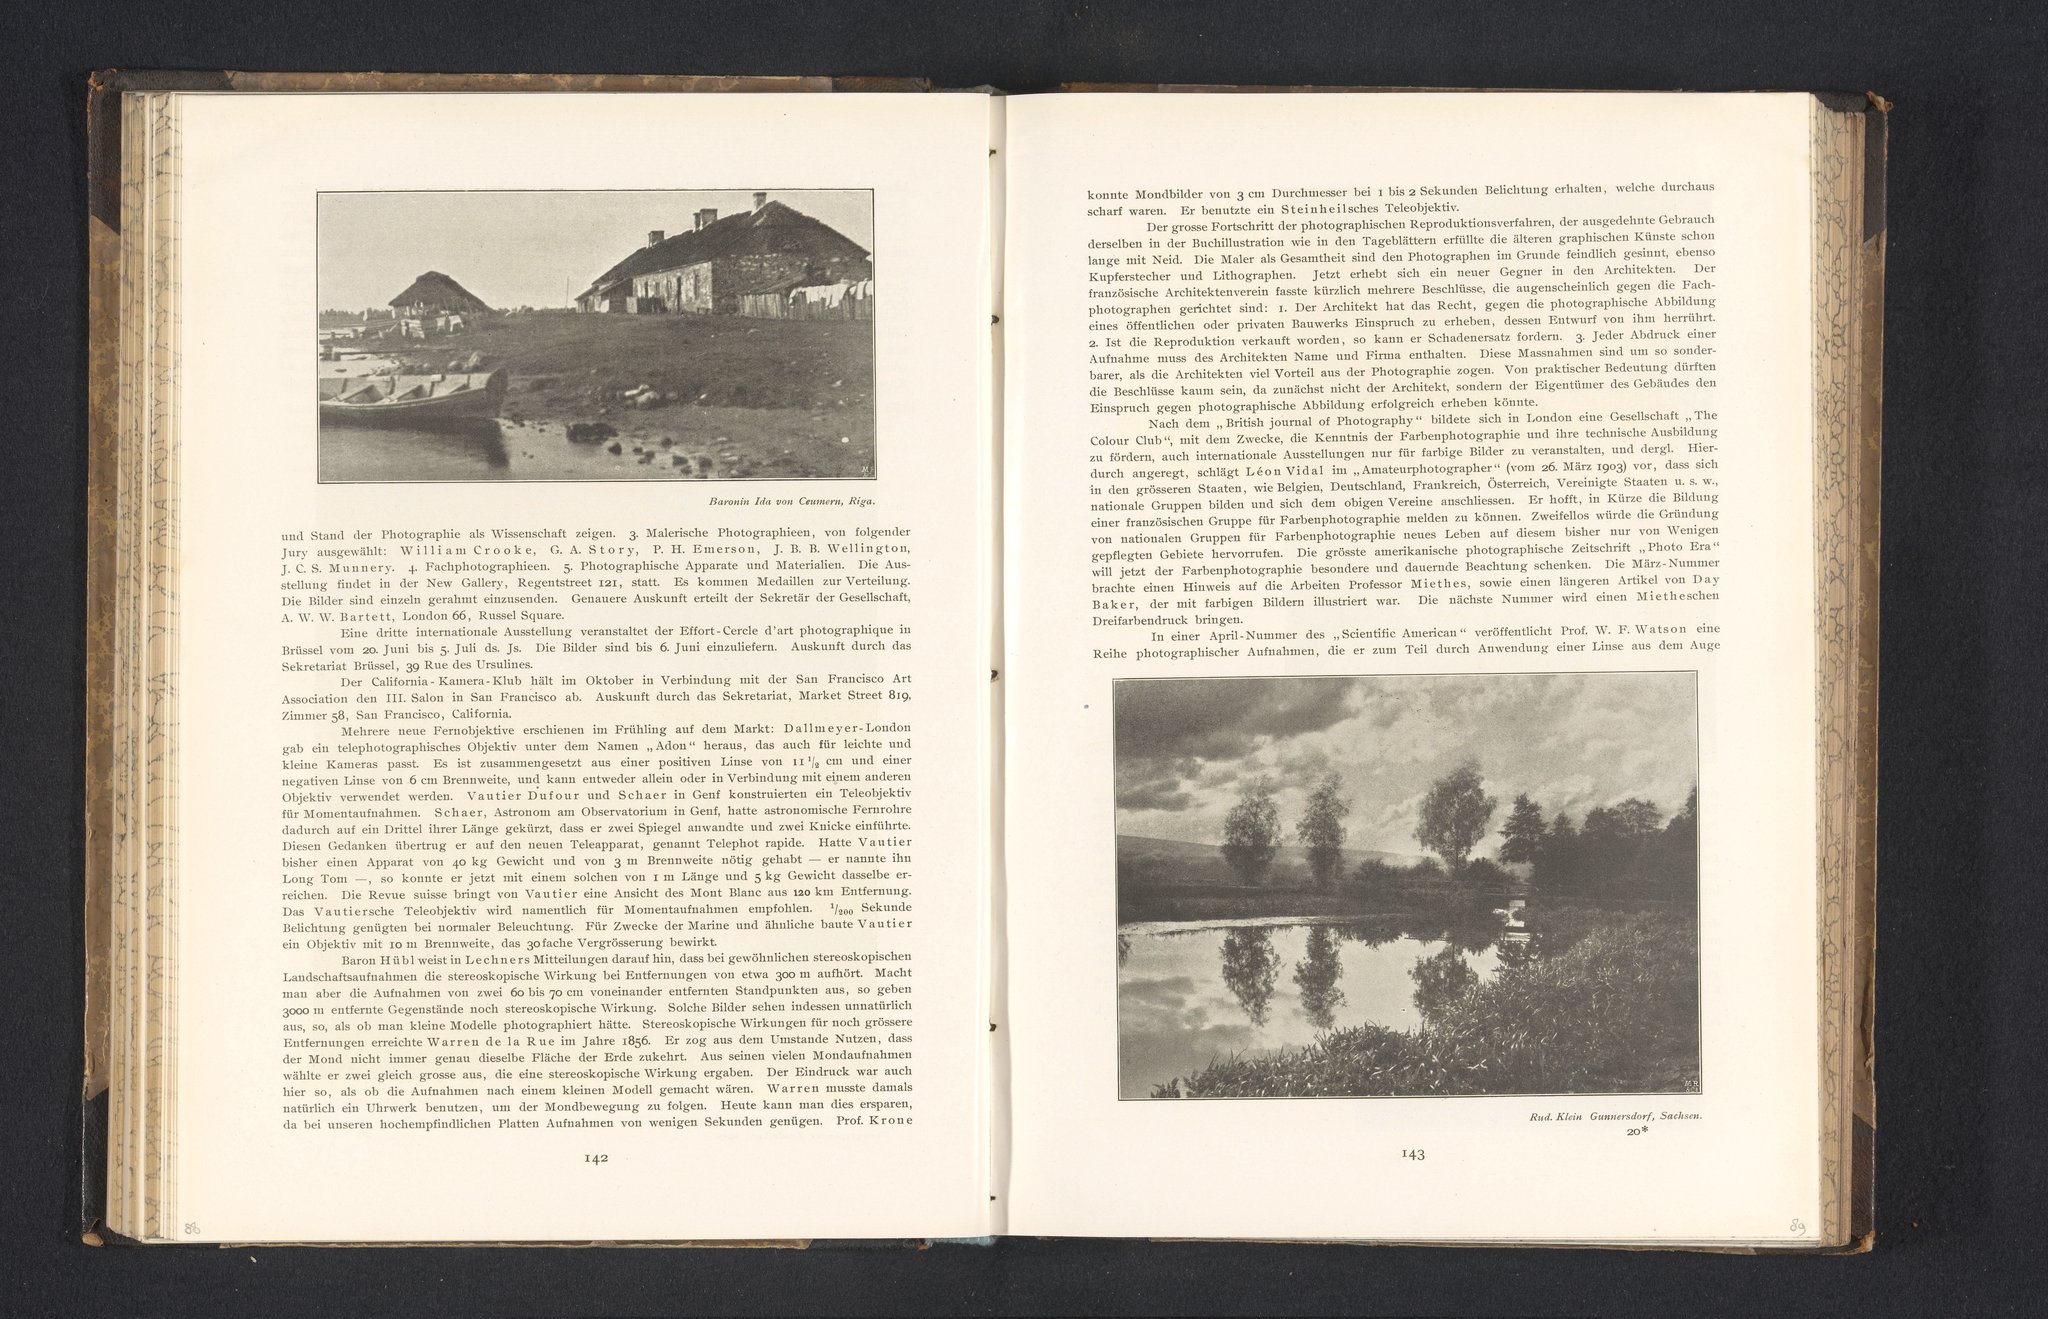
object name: page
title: Gezicht op een huis en een bijgebouw op de oever van een rivier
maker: ida von ceumern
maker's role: barones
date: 1898-1903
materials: paper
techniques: autotype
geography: berlin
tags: river bank, rural housing, e.g. country-house, villa, cottage